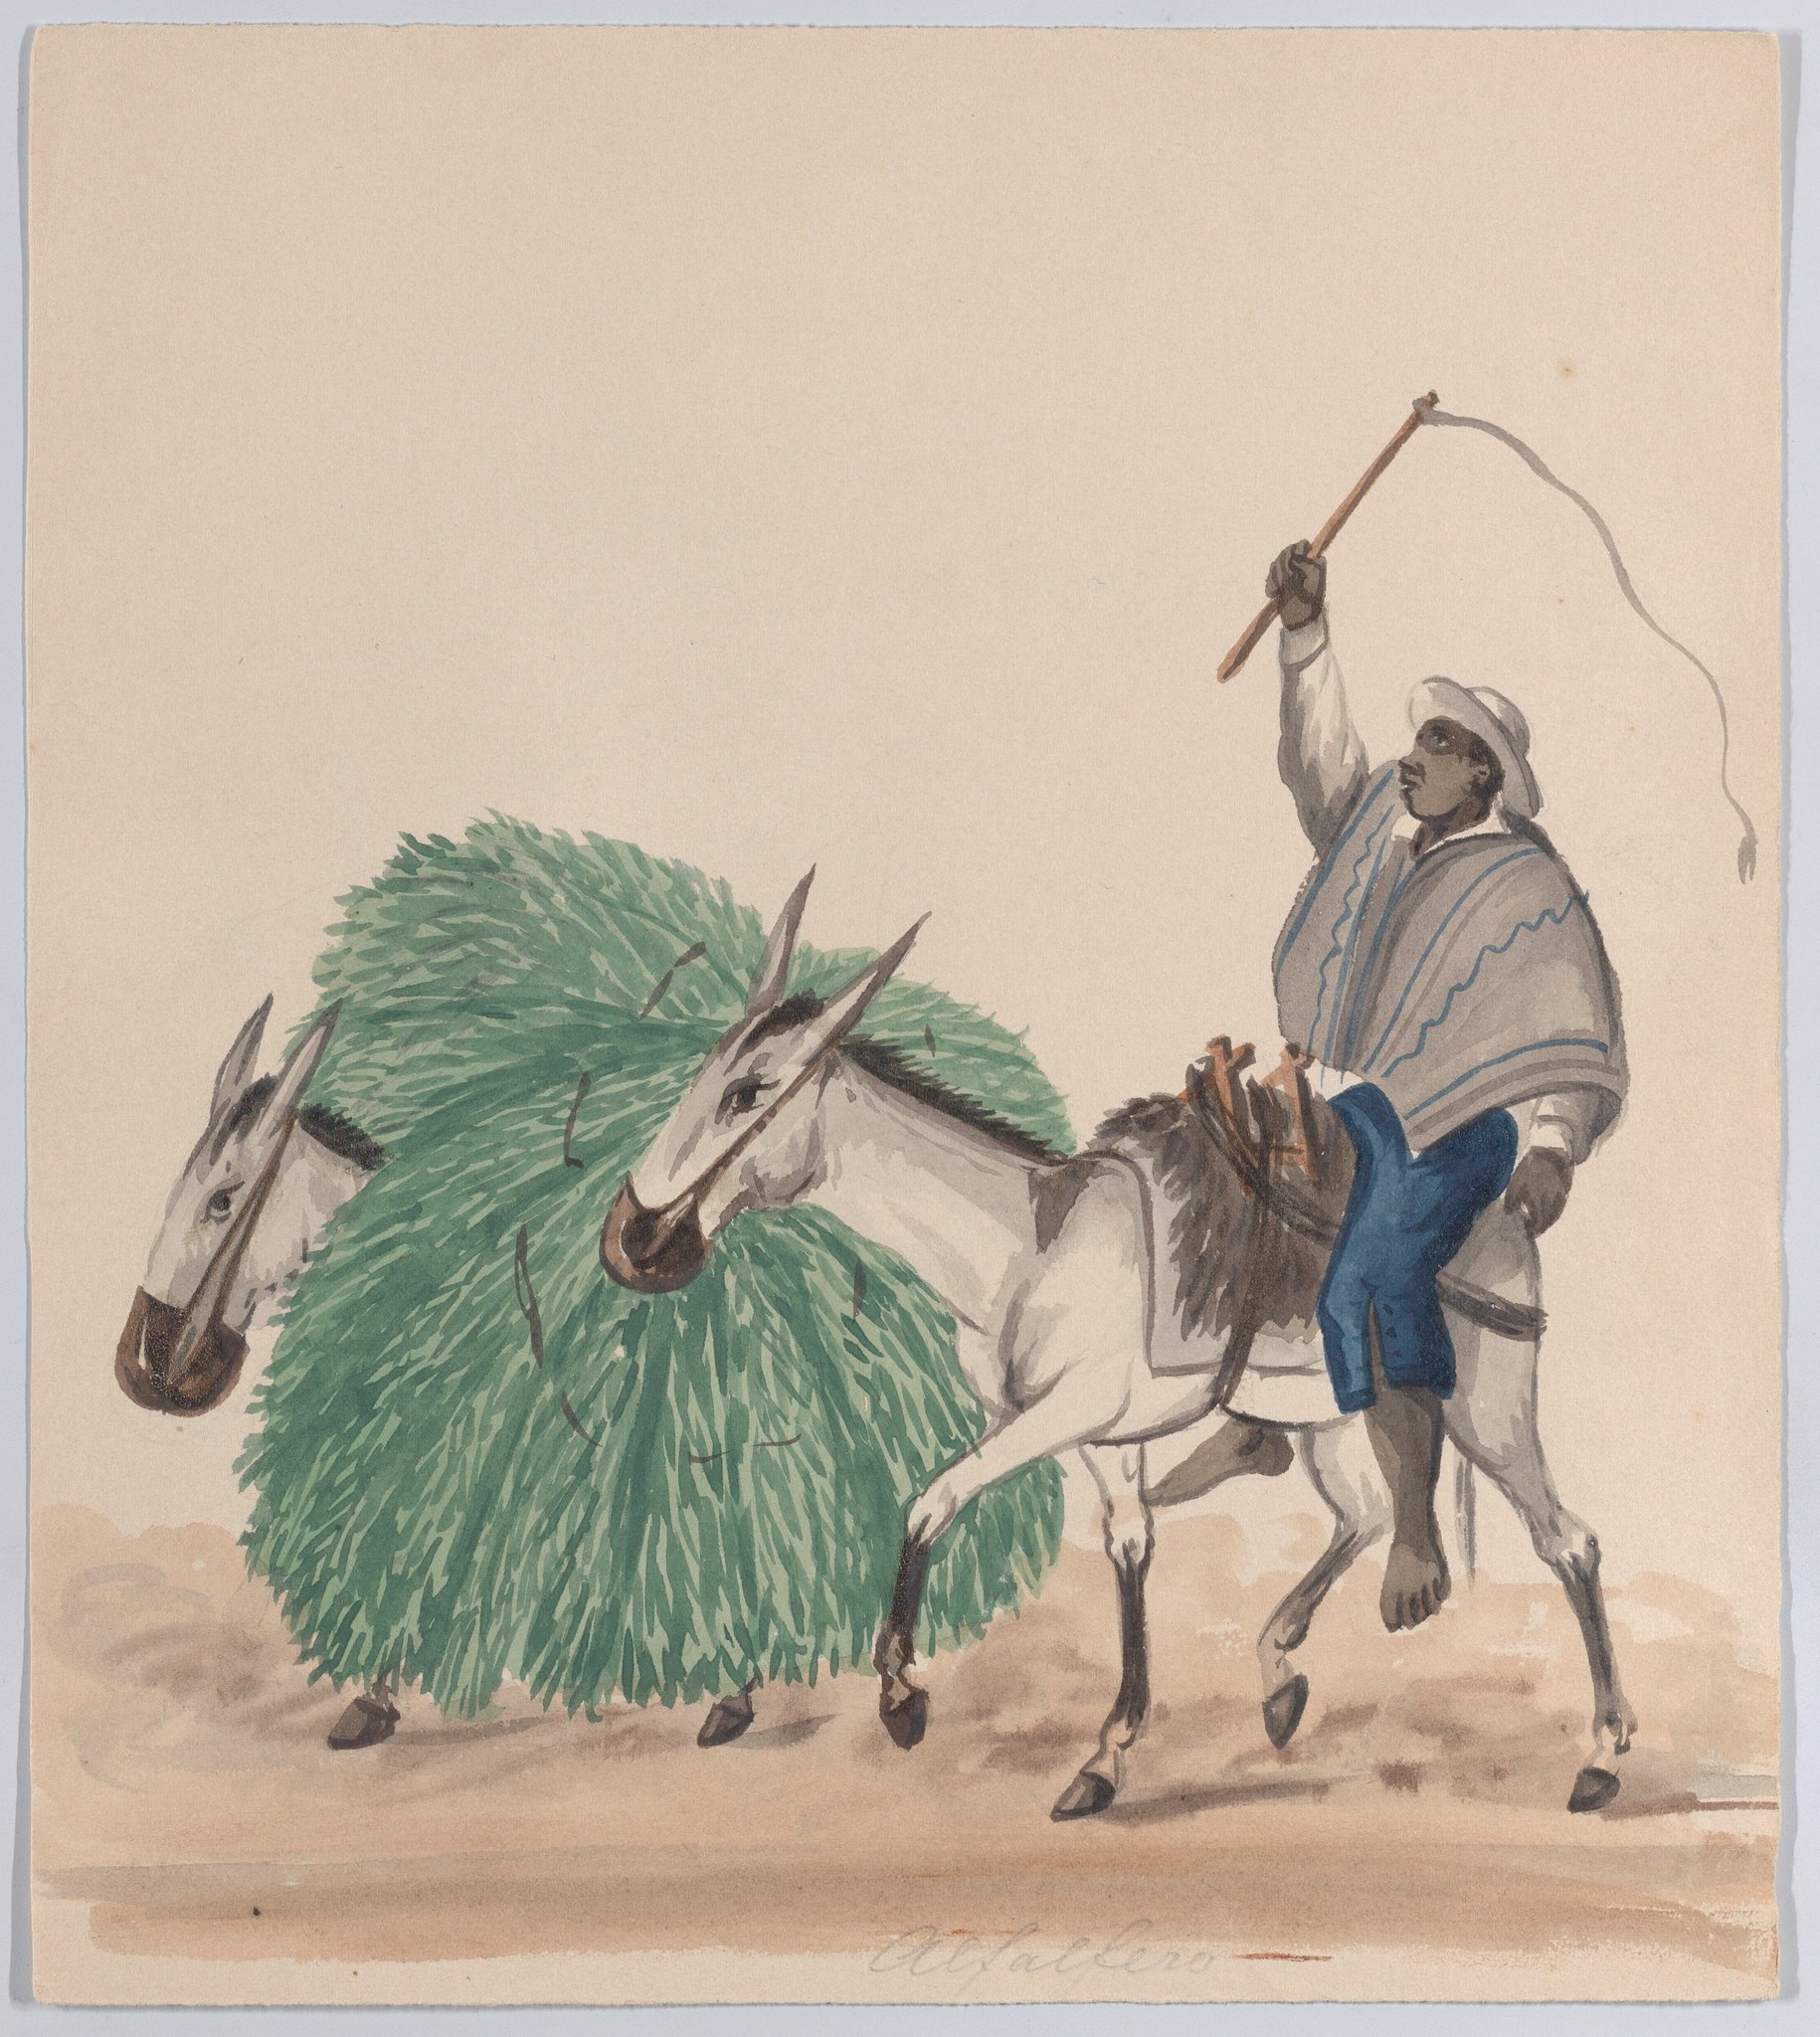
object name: drawing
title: A man riding a mule, his whip raised, another mule loaded with grass alongside, from a group of drawings depicting Peruvian dress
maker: francisco (pancho) fierro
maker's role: artist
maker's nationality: african peruvian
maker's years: 1807-1879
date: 1848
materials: watercolor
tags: men,women